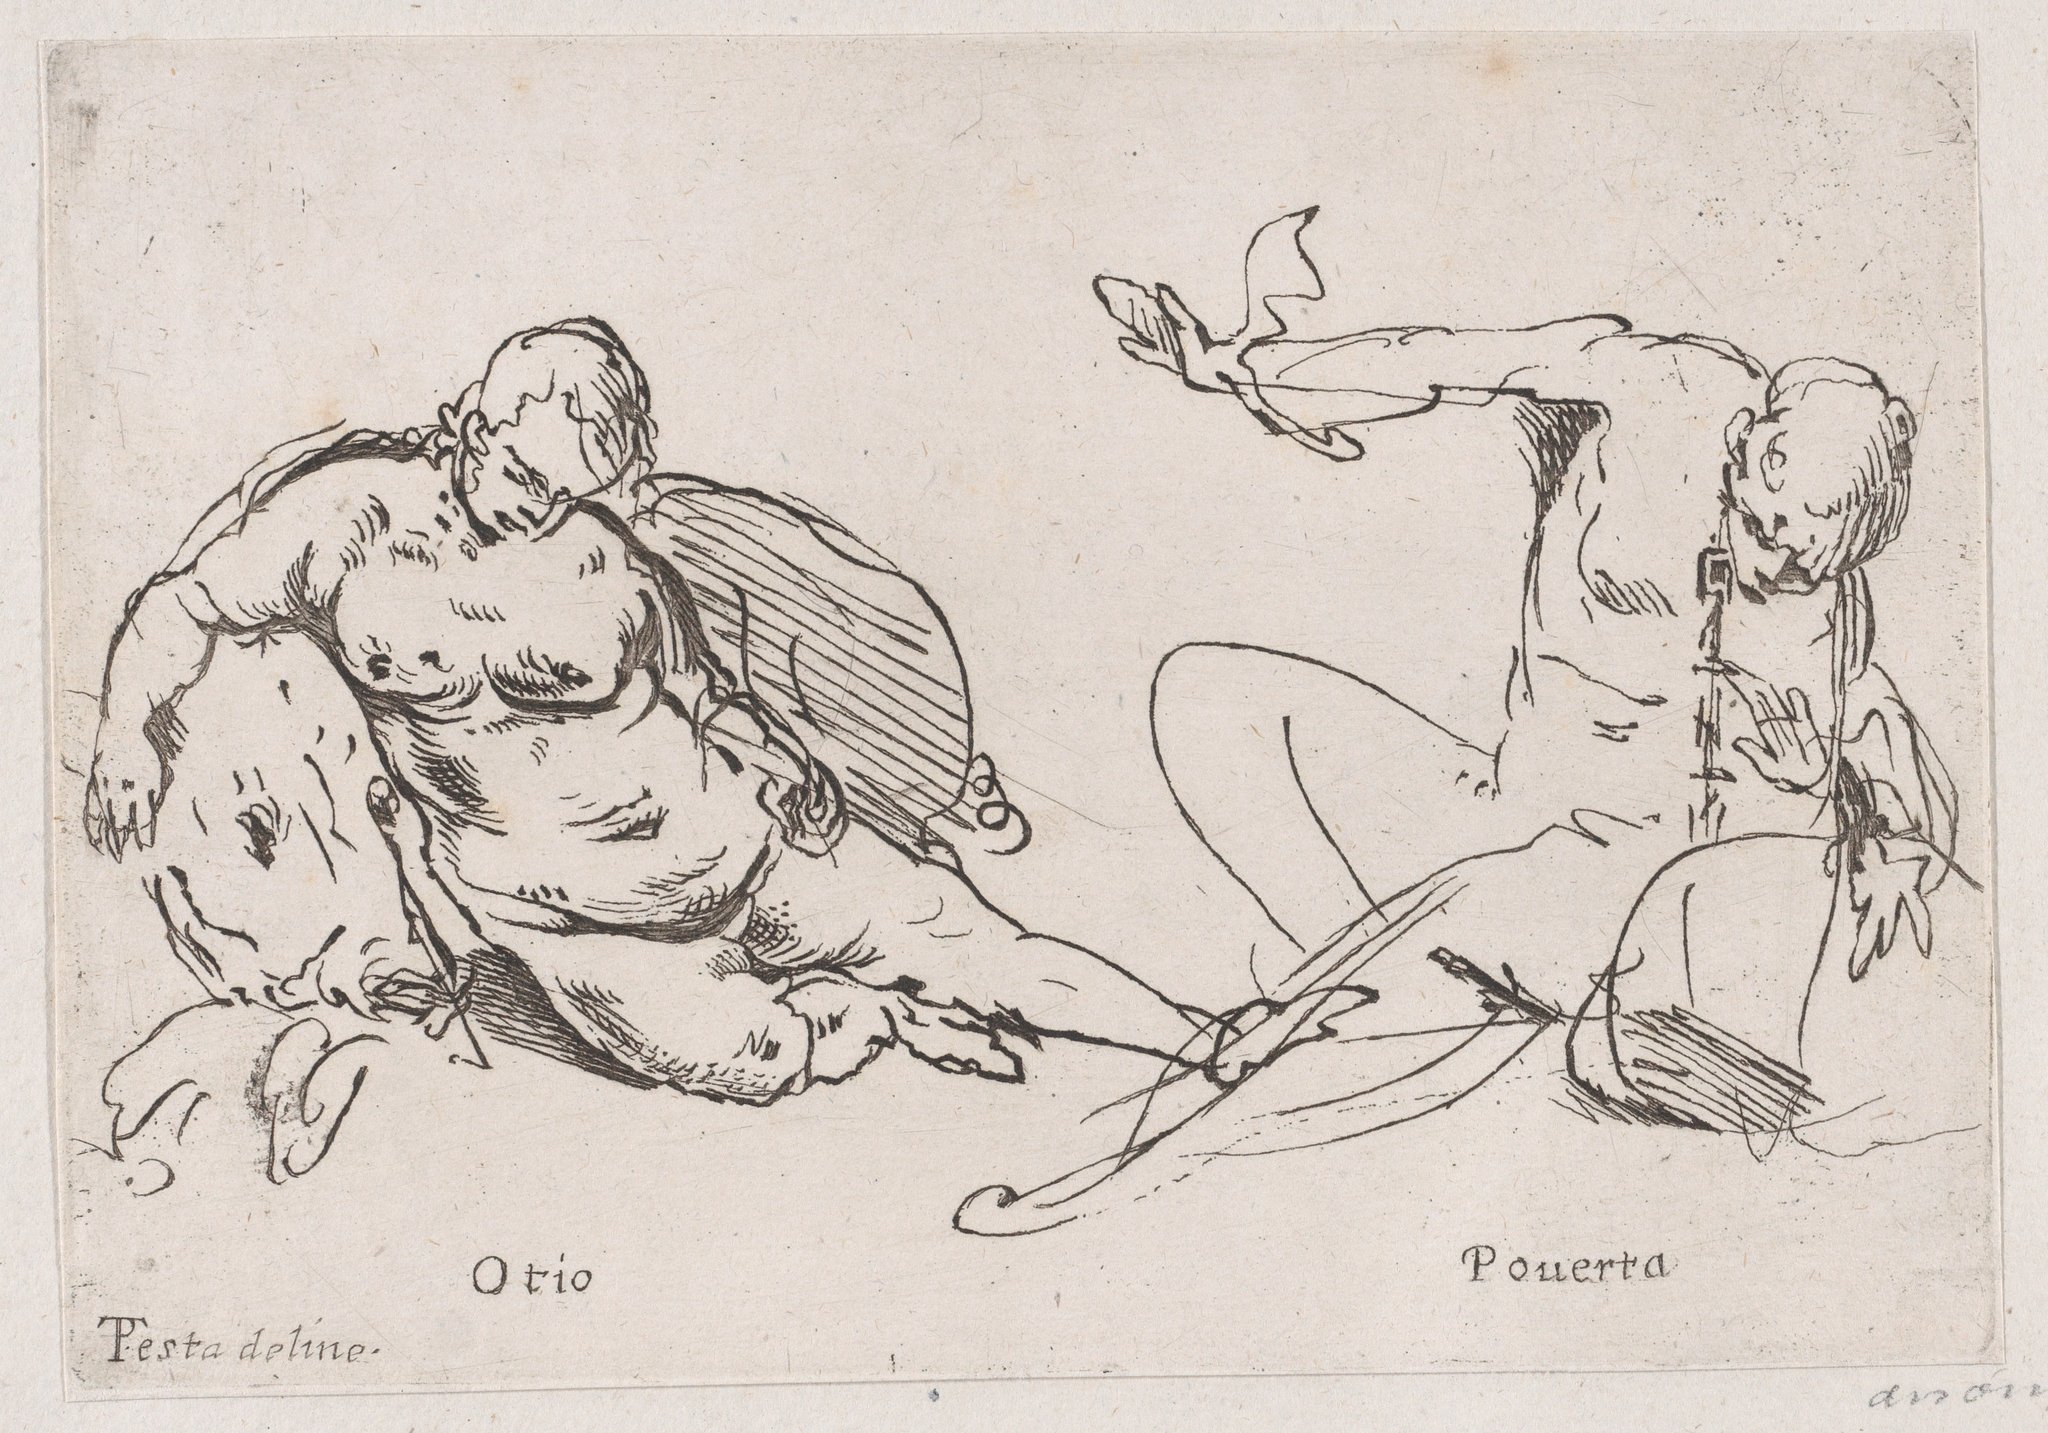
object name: print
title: Two figures representing Sloth and Poverty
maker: anonymous, 18th century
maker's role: artist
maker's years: 1700-1800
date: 1700-1800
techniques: etching